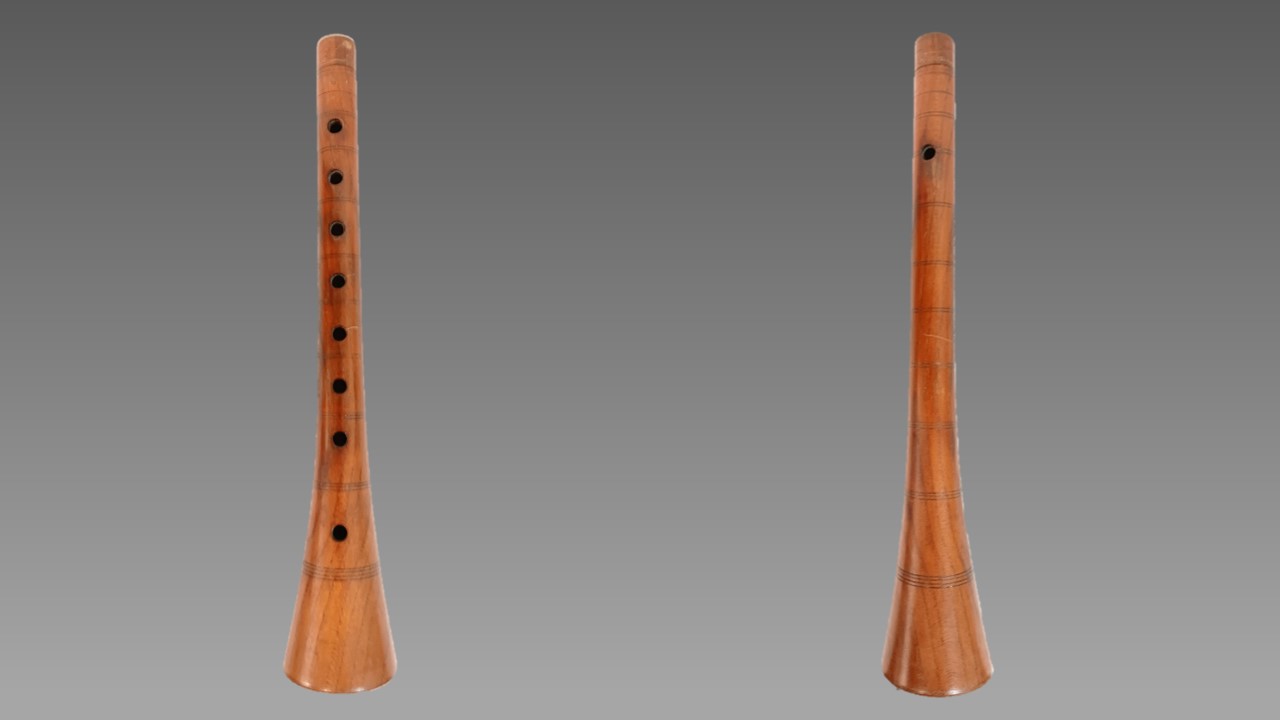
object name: zurna ზურნა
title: Zurna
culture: georgian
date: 1801-1900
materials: wood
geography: georgia